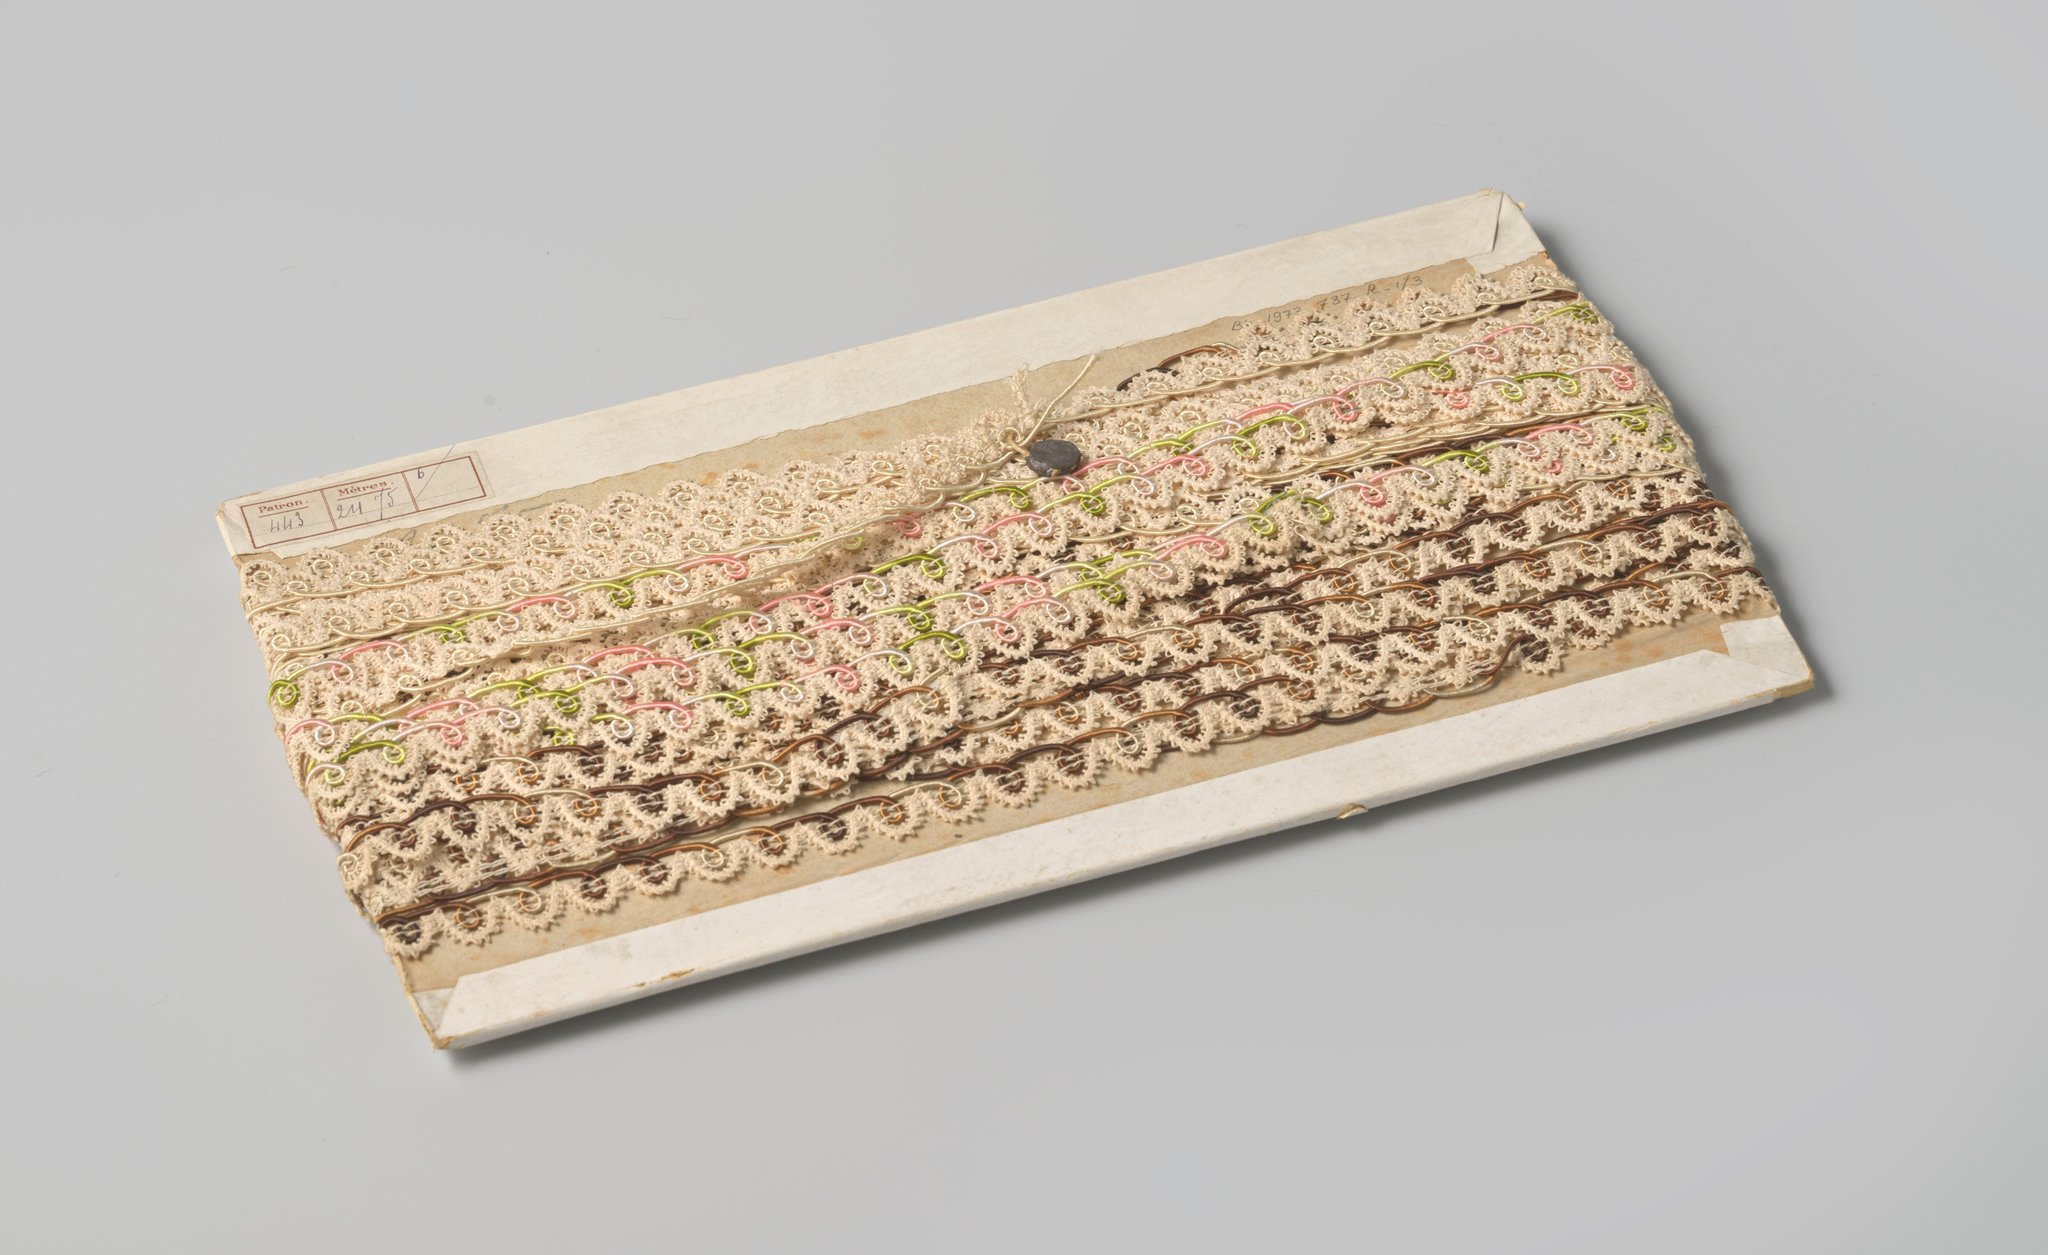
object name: strip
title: Passement van geschulpte witte kant voorzien van picots doorweven met een ondulerende glanzende afwisselend rose groene draad, op karton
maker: gustav schnitzler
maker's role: paraplufabrikant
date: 1925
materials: cardboard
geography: nijmegen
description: Passement van geschulpte witte kant voorzien van picots doorweven met een ondulerende glanzende afwisselend rose groene draad, op karton.